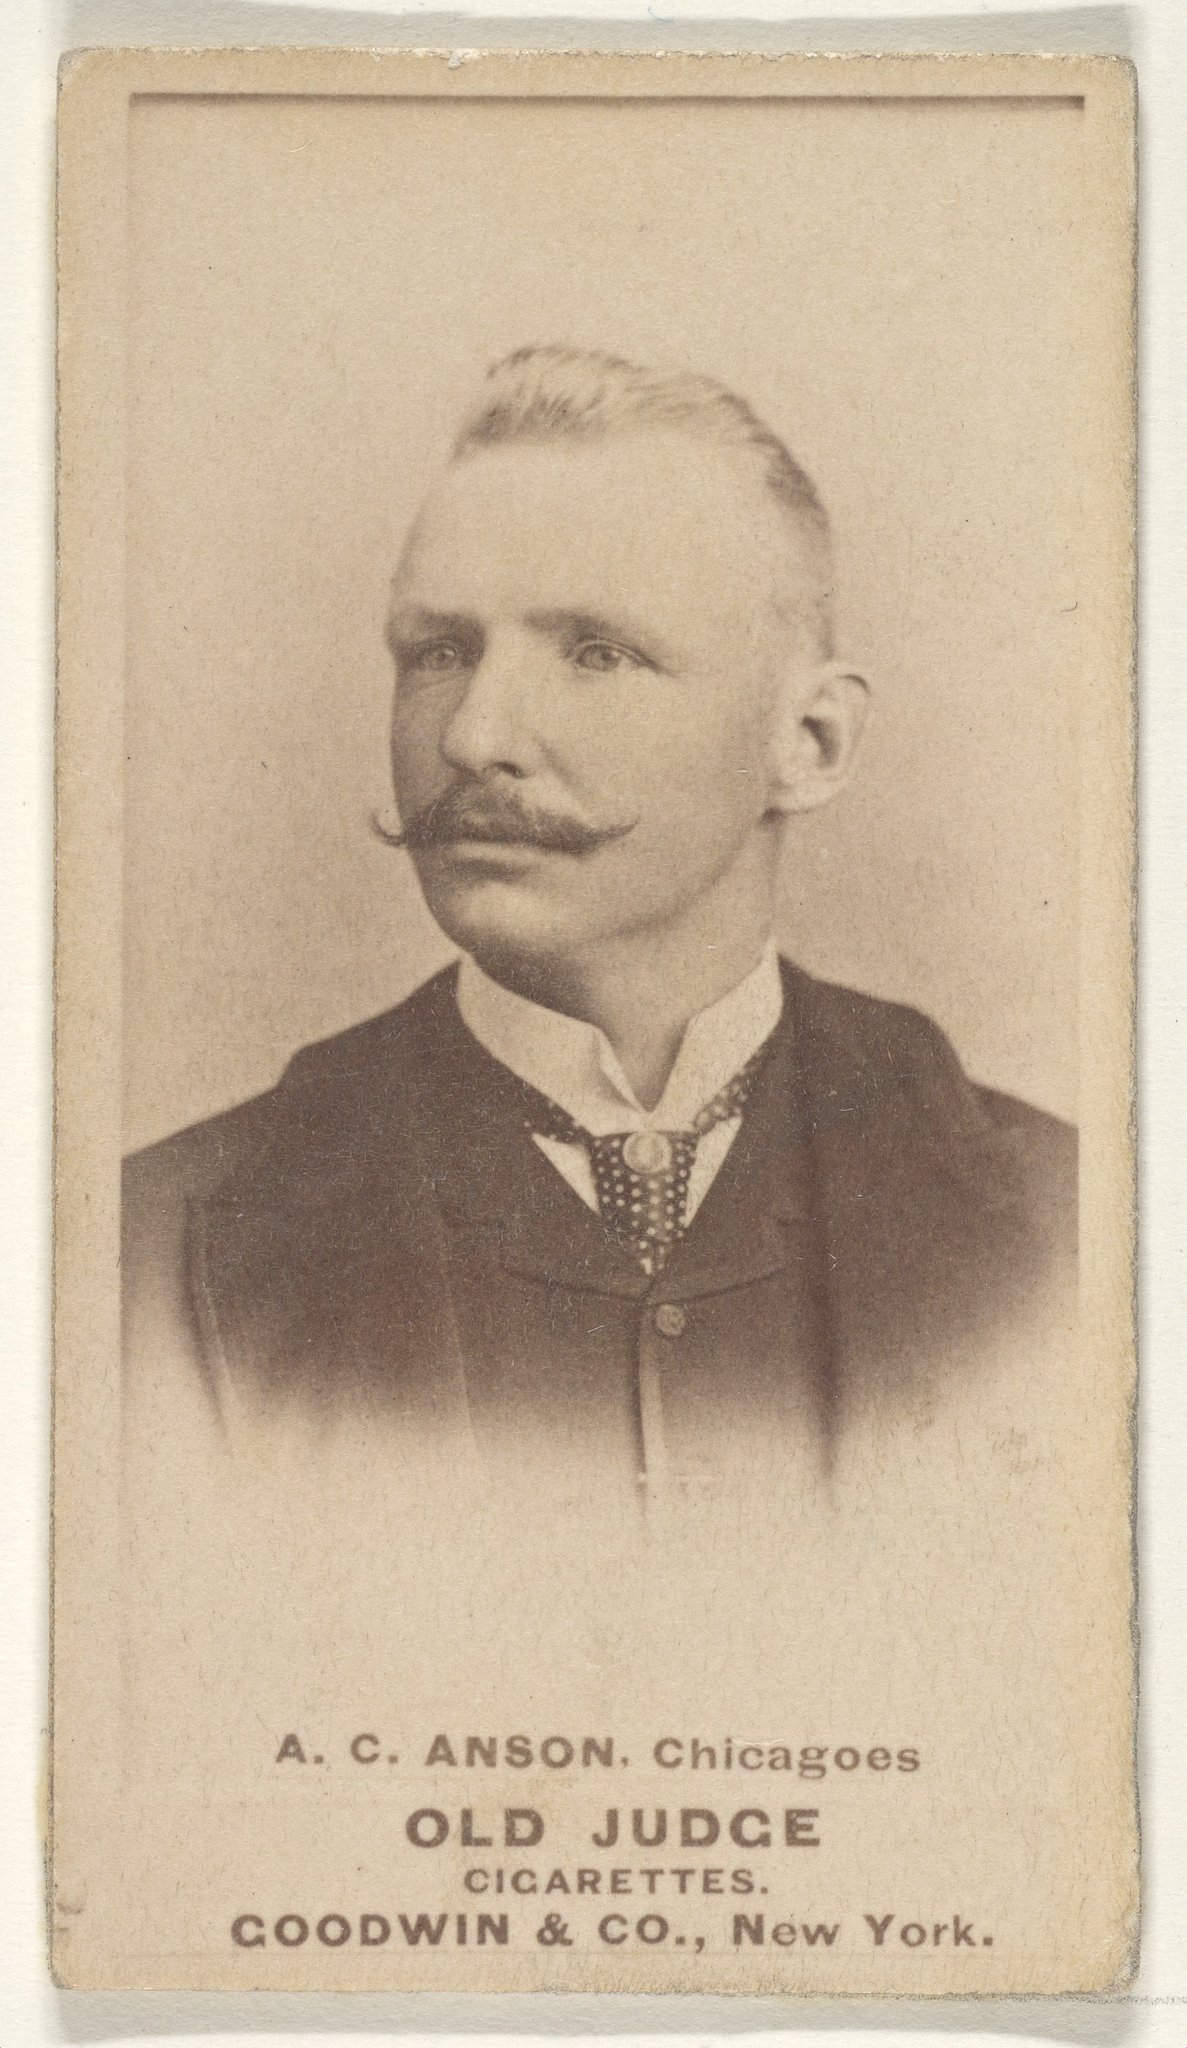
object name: baseball card, photograph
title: A.C. Anson, Captain, Chicago, from the Old Judge series (N172) for Old Judge Cigarettes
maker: goodwin & company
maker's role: publisher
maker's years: 1850-1950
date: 1887-1890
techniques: albumen silver print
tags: men,portraits,baseball